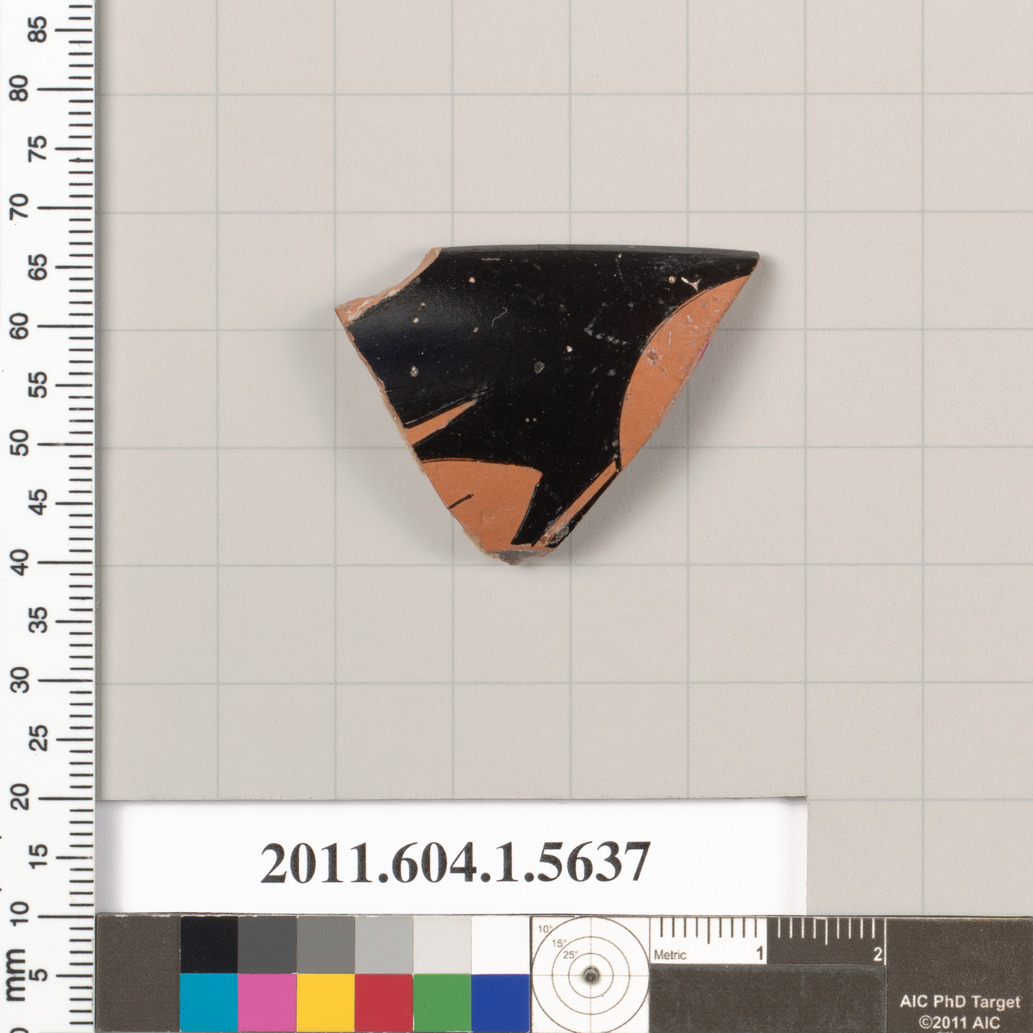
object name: kylix fragment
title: Terracotta rim fragment of a kylix (drinking cup)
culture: greek, attic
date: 500-480 BCE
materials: terracotta